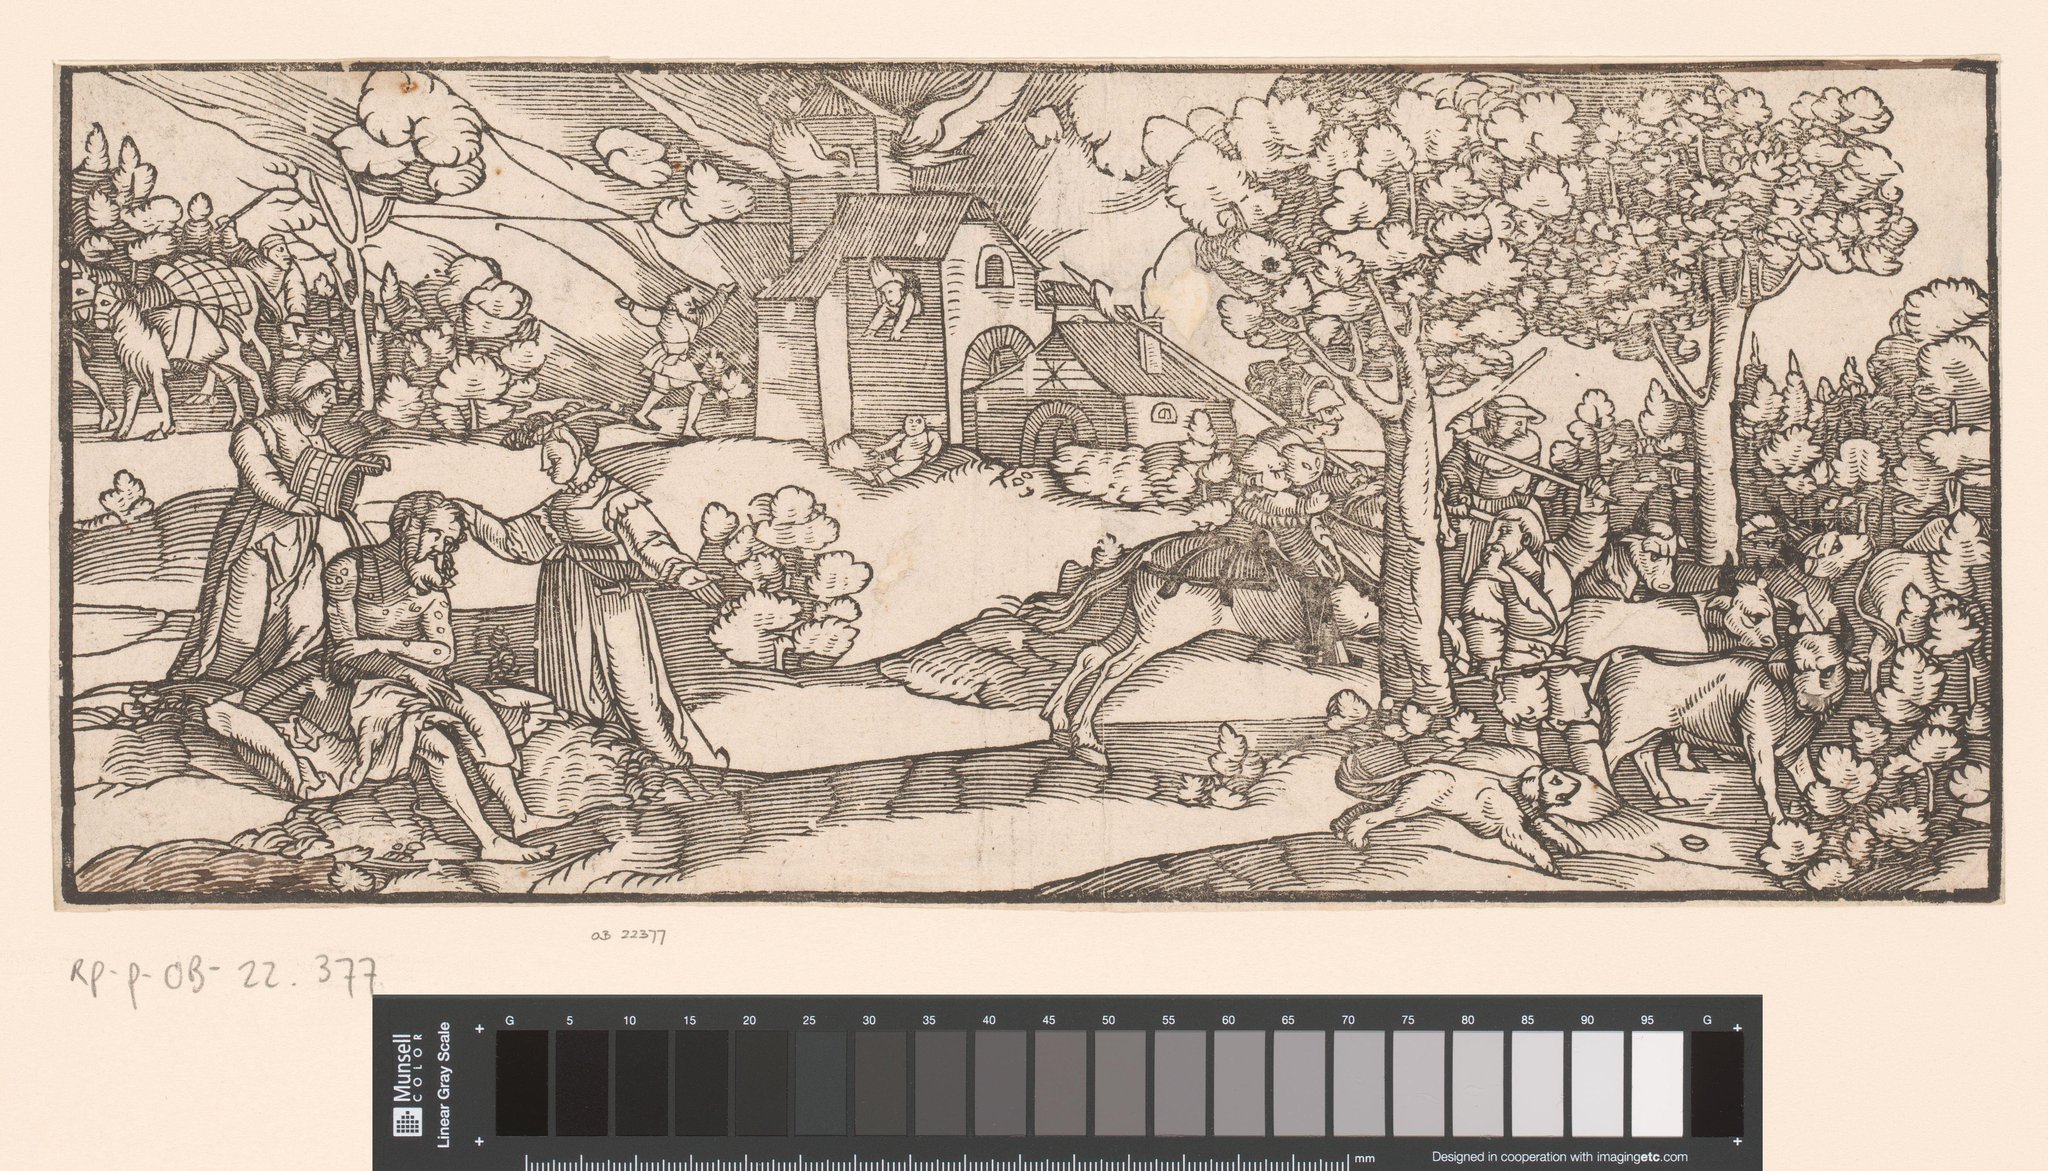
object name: print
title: Historie van Job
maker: Anonymous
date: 1490-1538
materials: paper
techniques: woodcut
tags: the book of job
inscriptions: collector's mark: Lugt 240